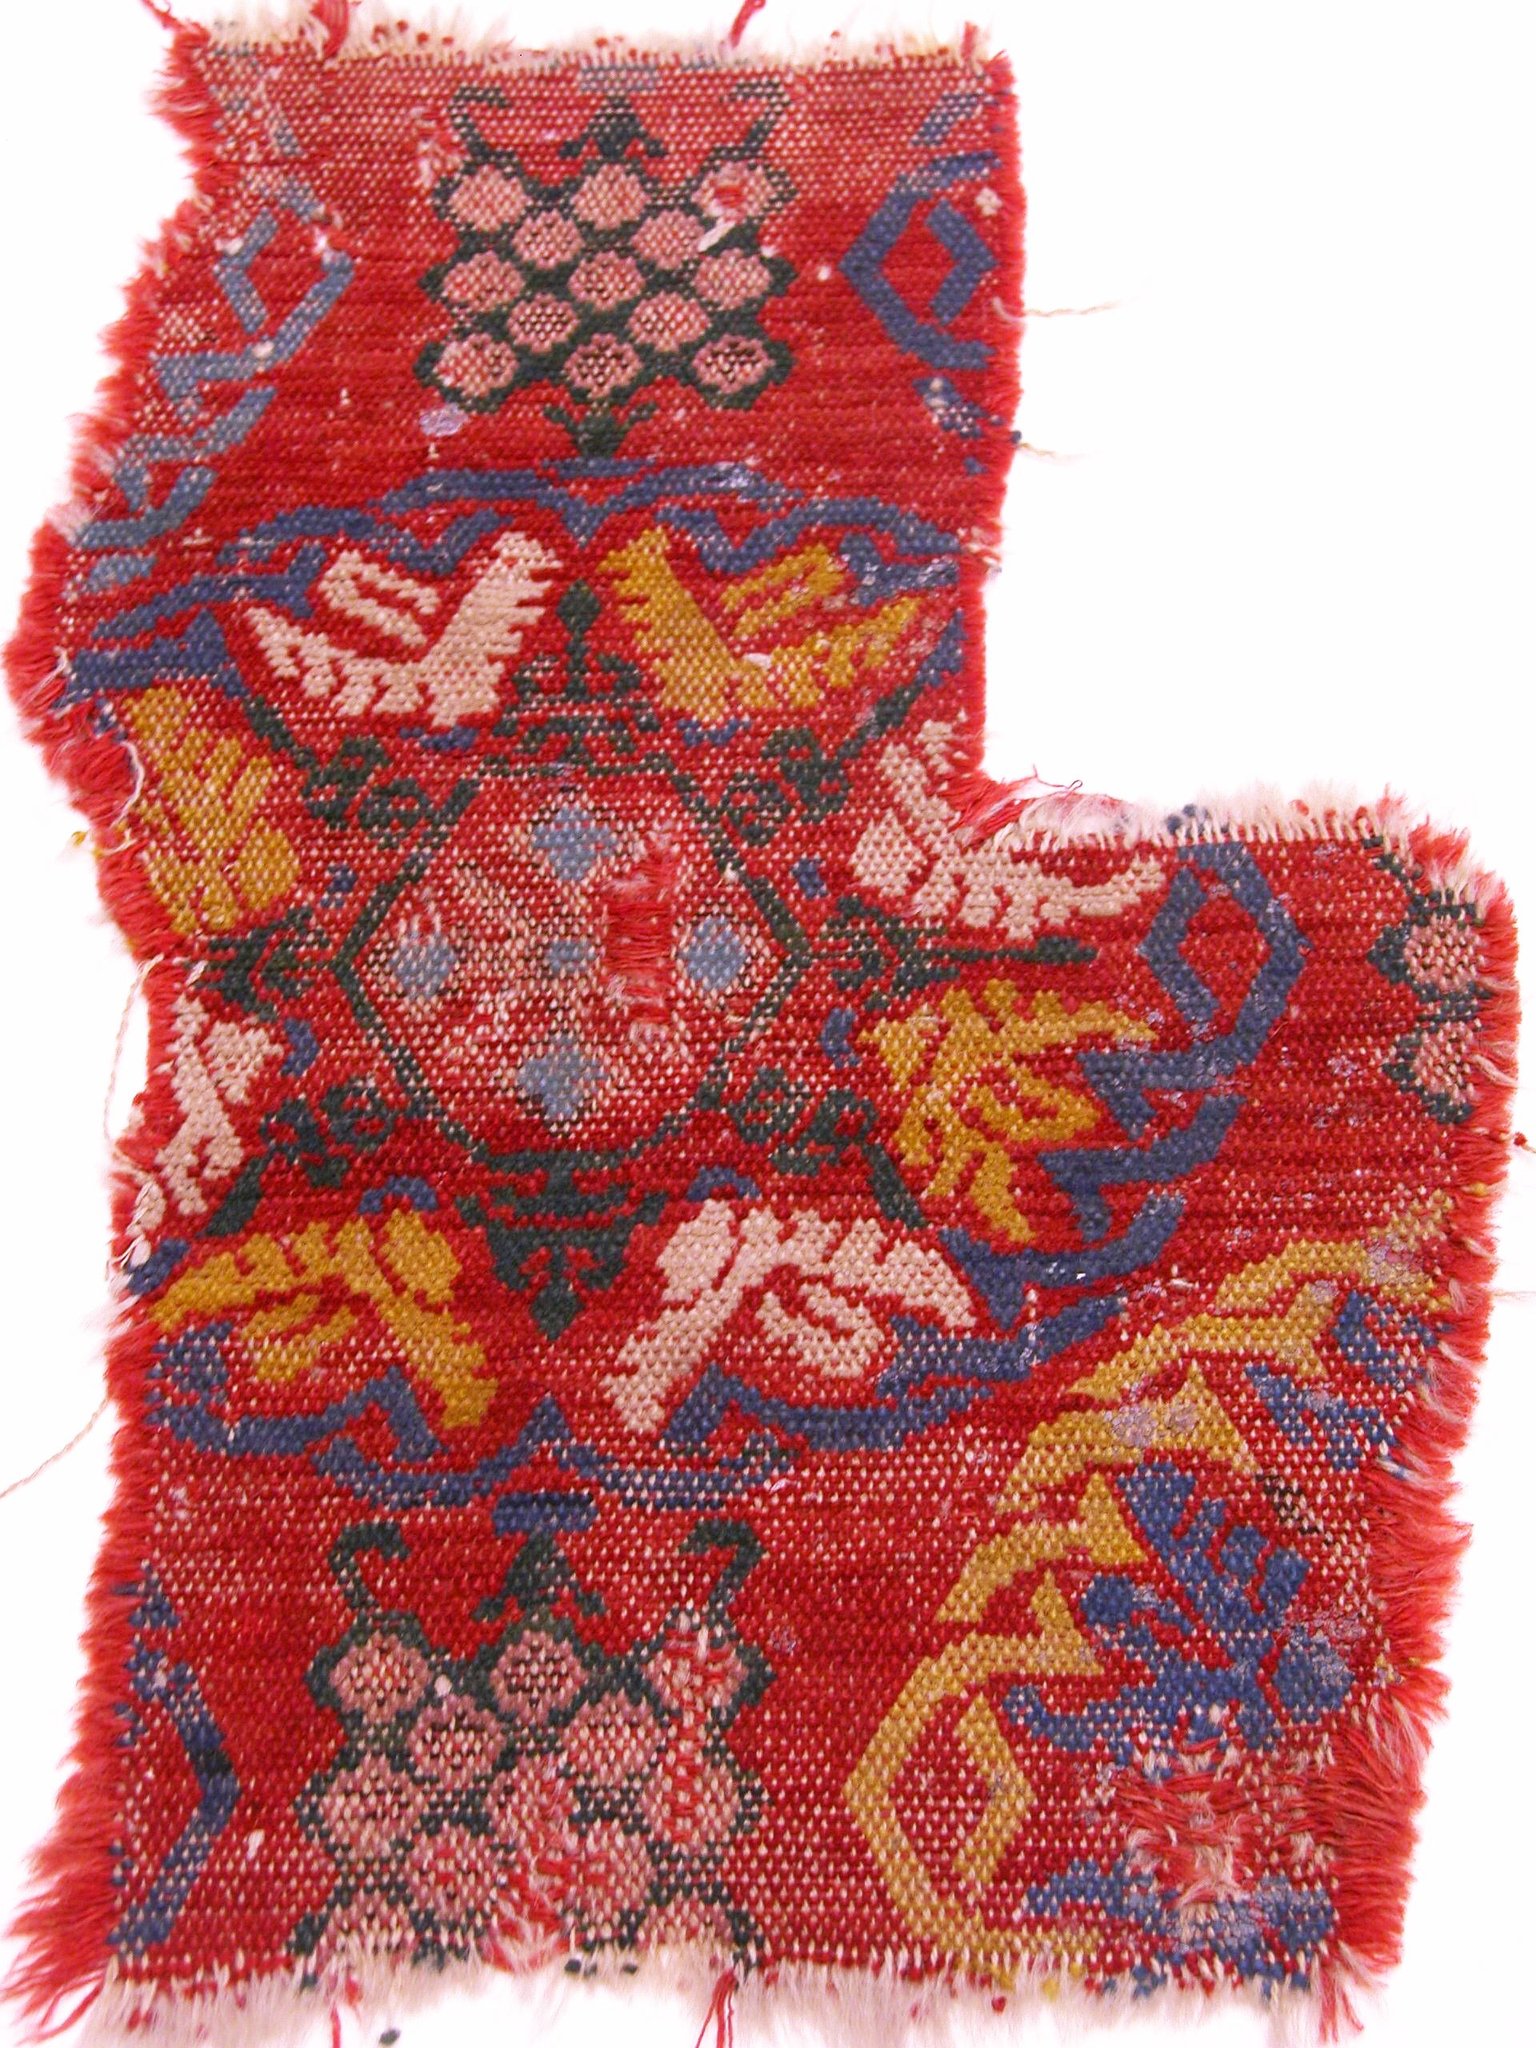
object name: carpet fragment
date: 1401-1600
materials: wool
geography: spain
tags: birds,medallions